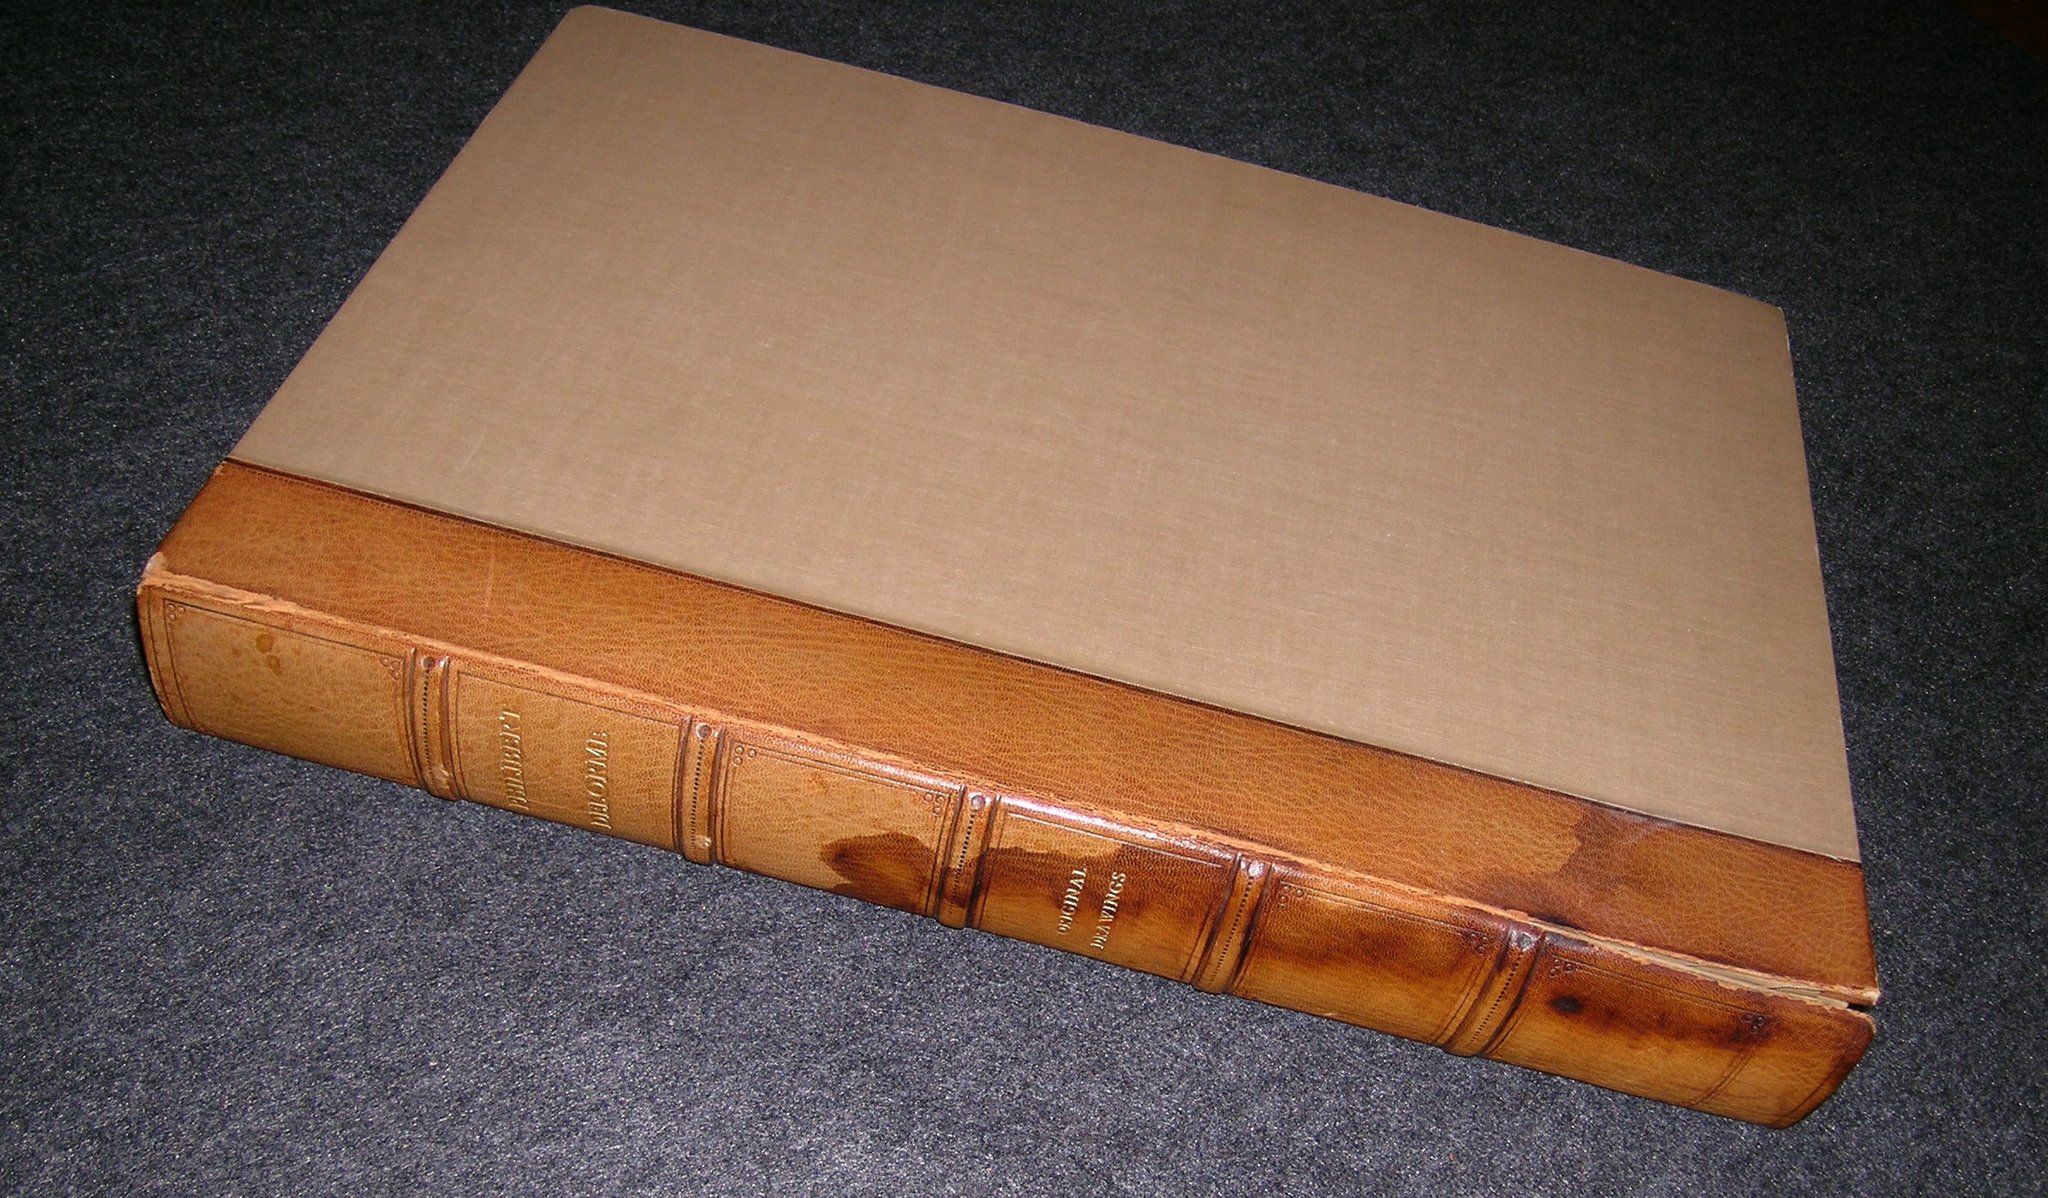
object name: collection ornament architecture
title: Goldschmidt Scrapbook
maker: anonymous, french, 16th century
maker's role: draftsman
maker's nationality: french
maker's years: 1500-1600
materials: chalk, ink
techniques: incising